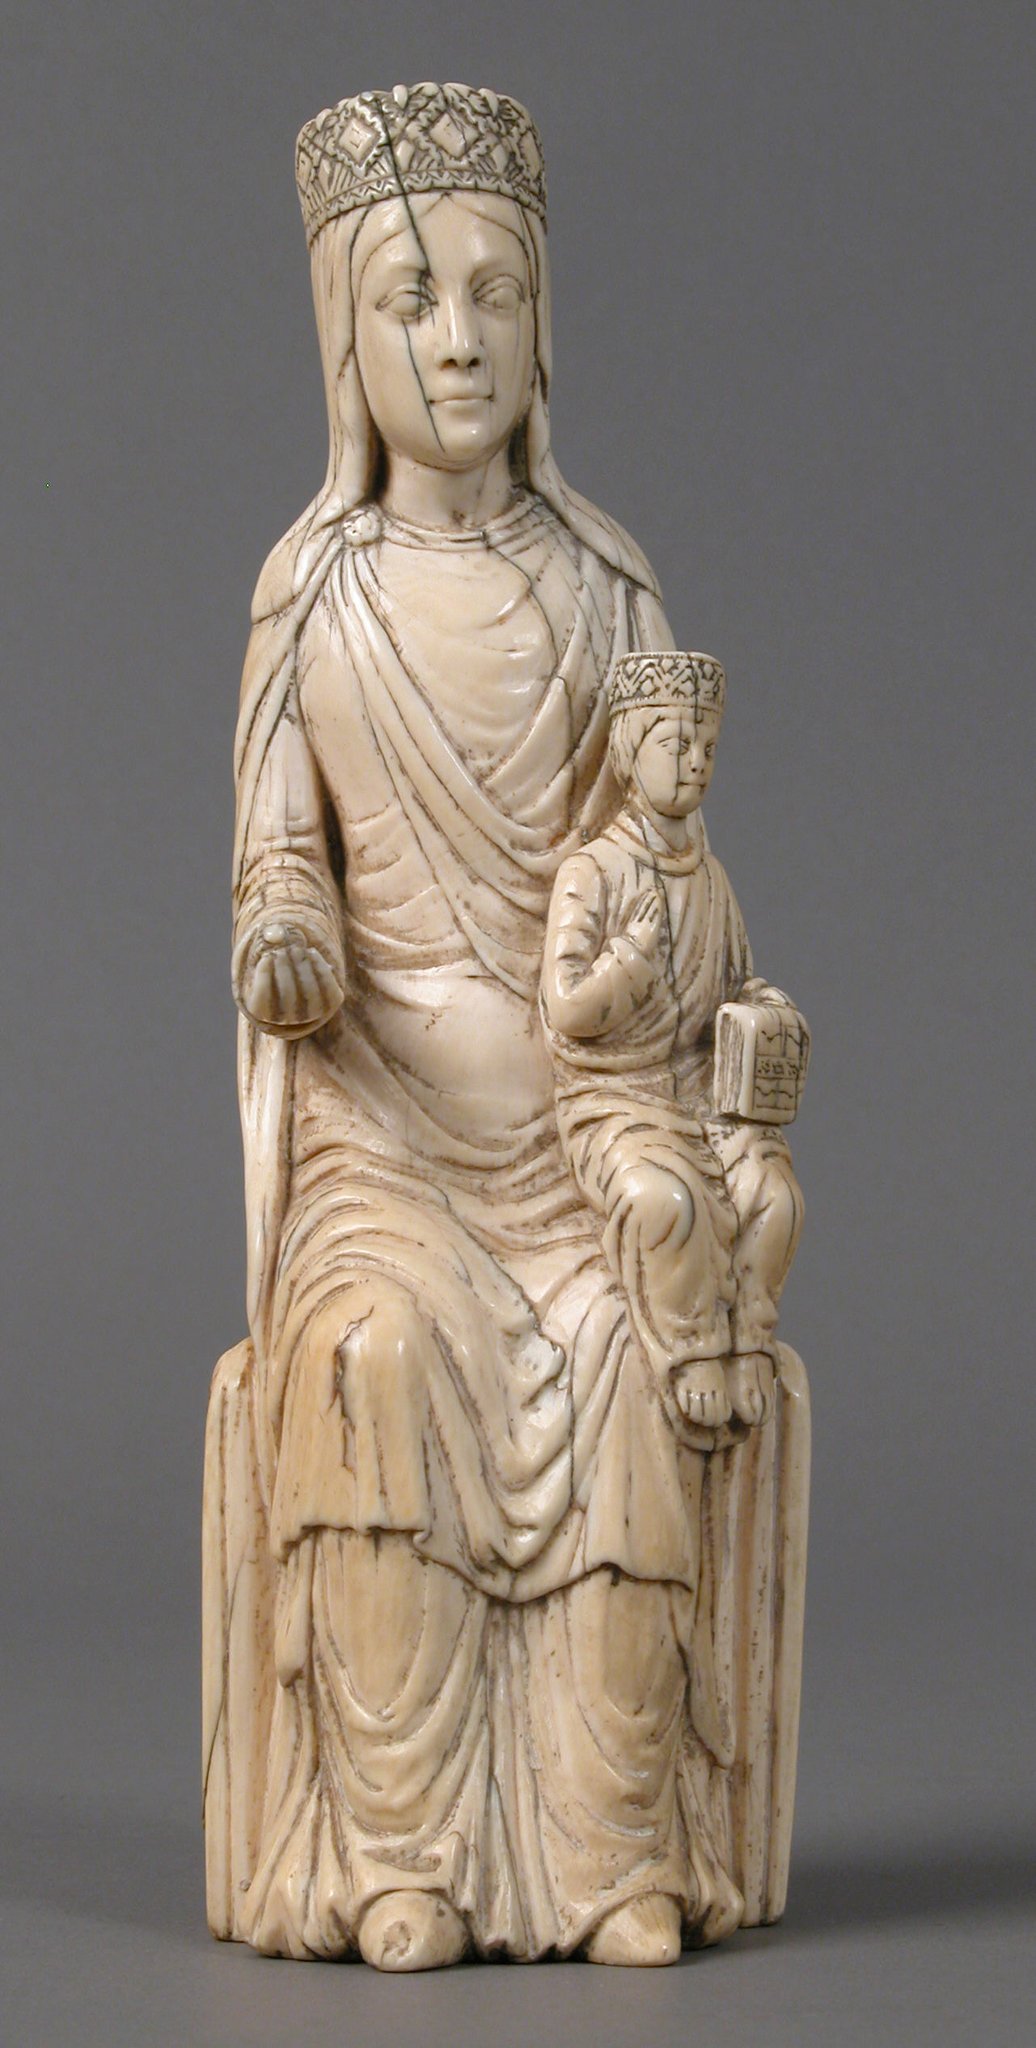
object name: sculpture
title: Virgin and Child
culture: european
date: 1801-1900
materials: ivory